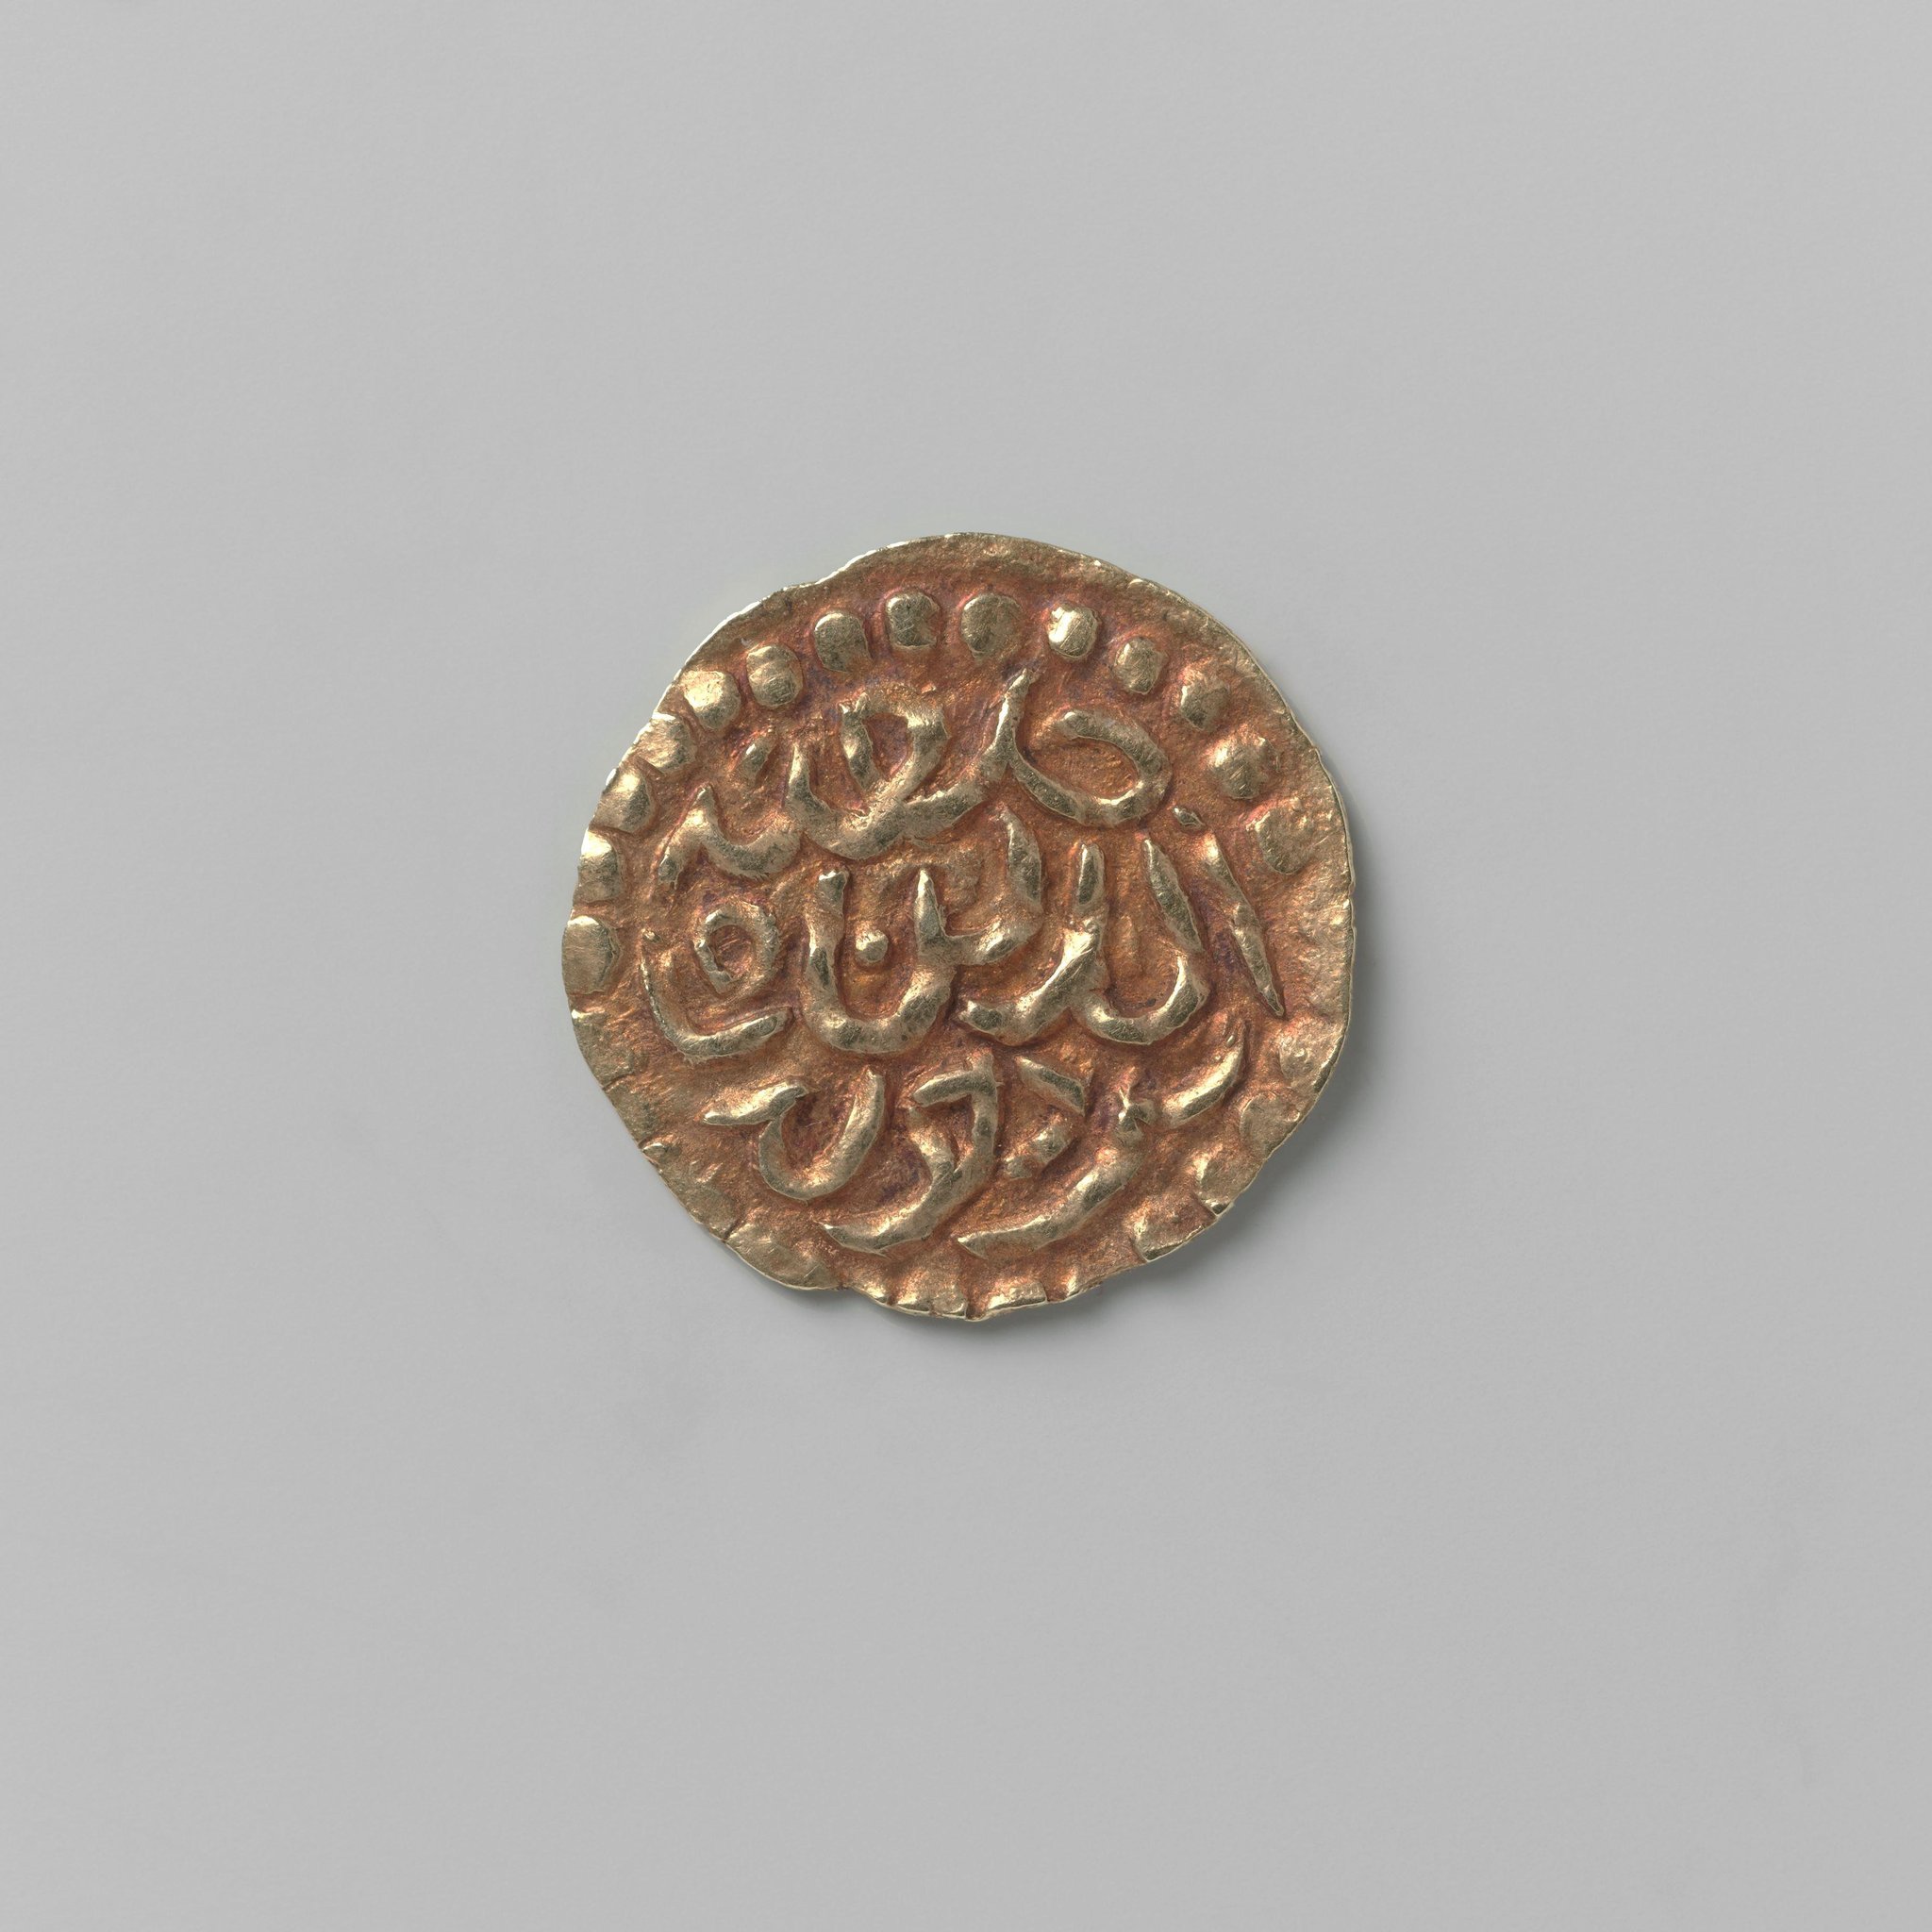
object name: ma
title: Mas van de Sultanah Tadj al-Alam van Atjeh, Sumatra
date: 1641-1675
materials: gold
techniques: striking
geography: aceh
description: Gouden munt. Voorzijde: drieregelig opschrift in Arabische lettertekens. Keerzijde: drieregelig opschrift in Arabische lettertekens.